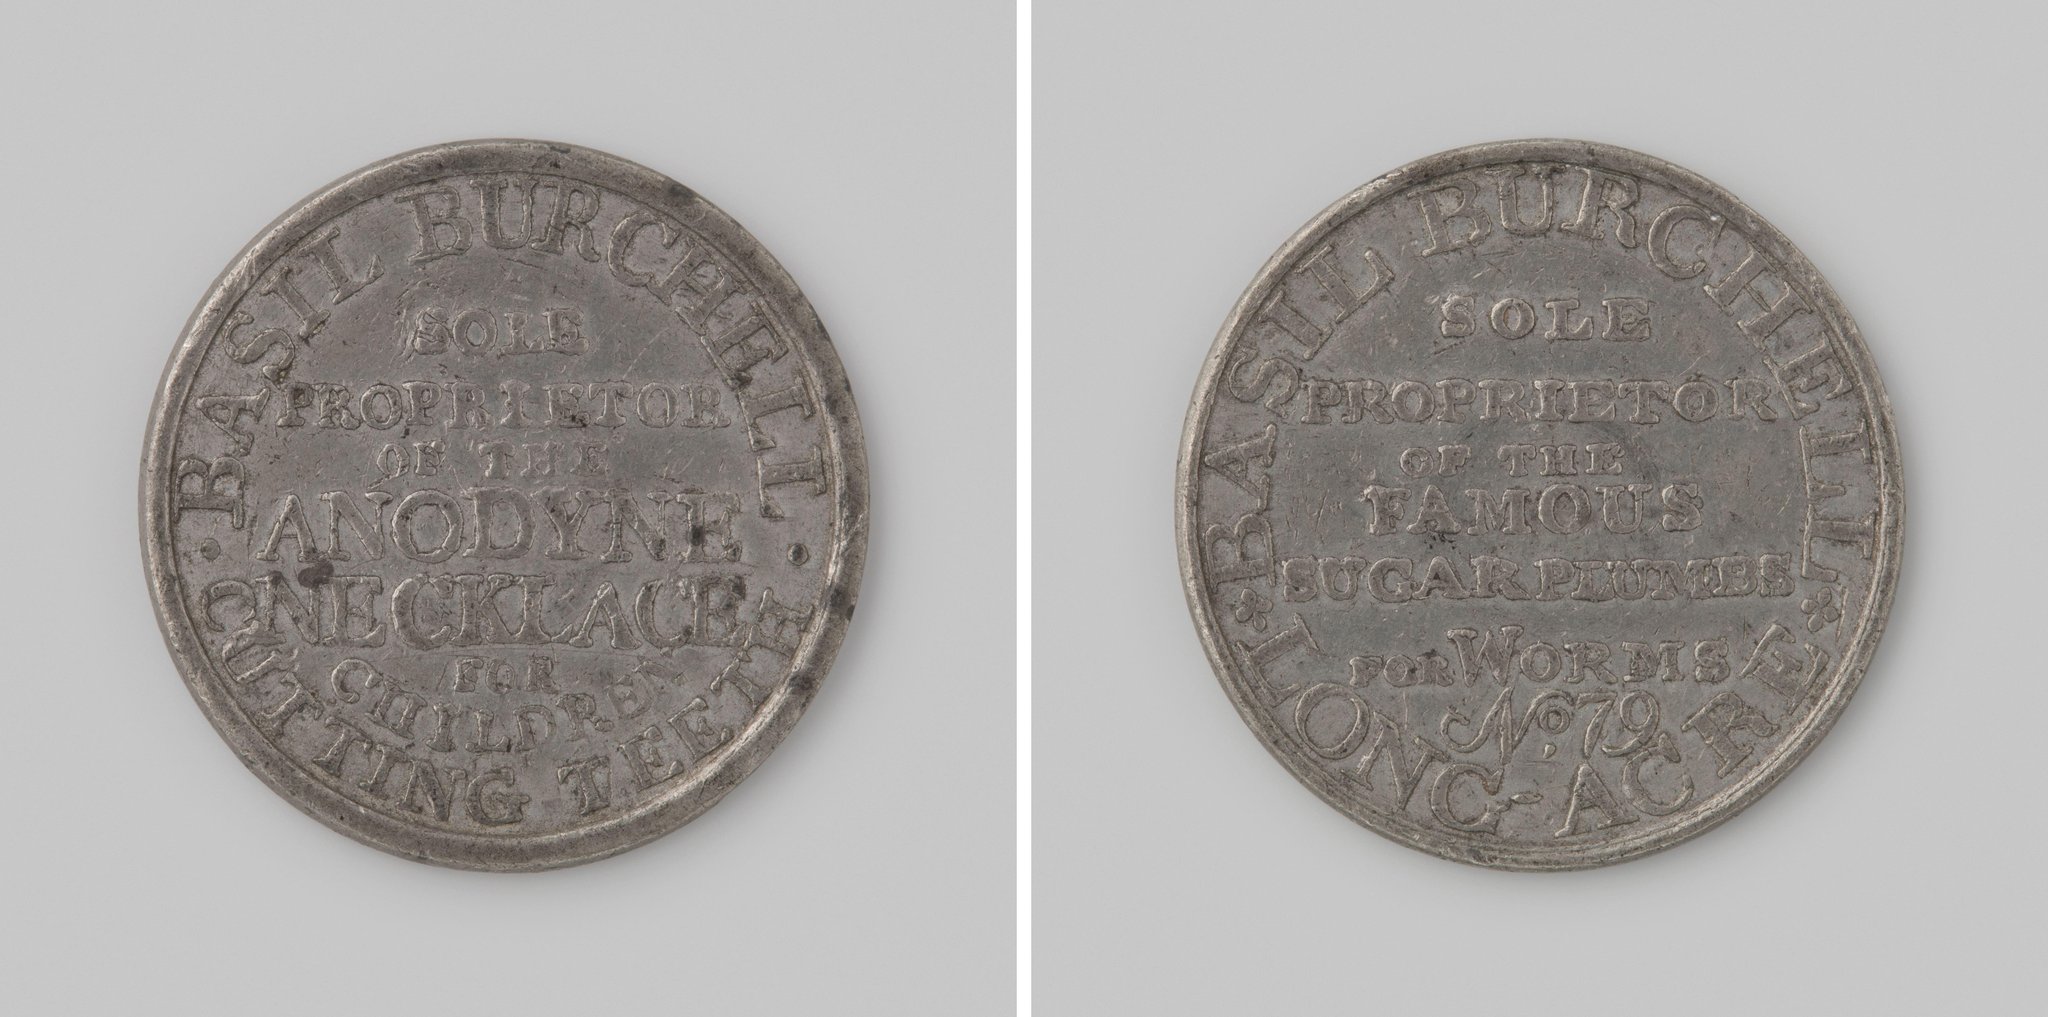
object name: history medal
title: Engelse reclamepenning voor Basil Burchell te Long Acre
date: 1870-1900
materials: tin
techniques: striking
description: Tinnen penning, op de voorzijde zeven regels tekst met omschrift, op de keerzijde zeven regels tekst met omschrift.